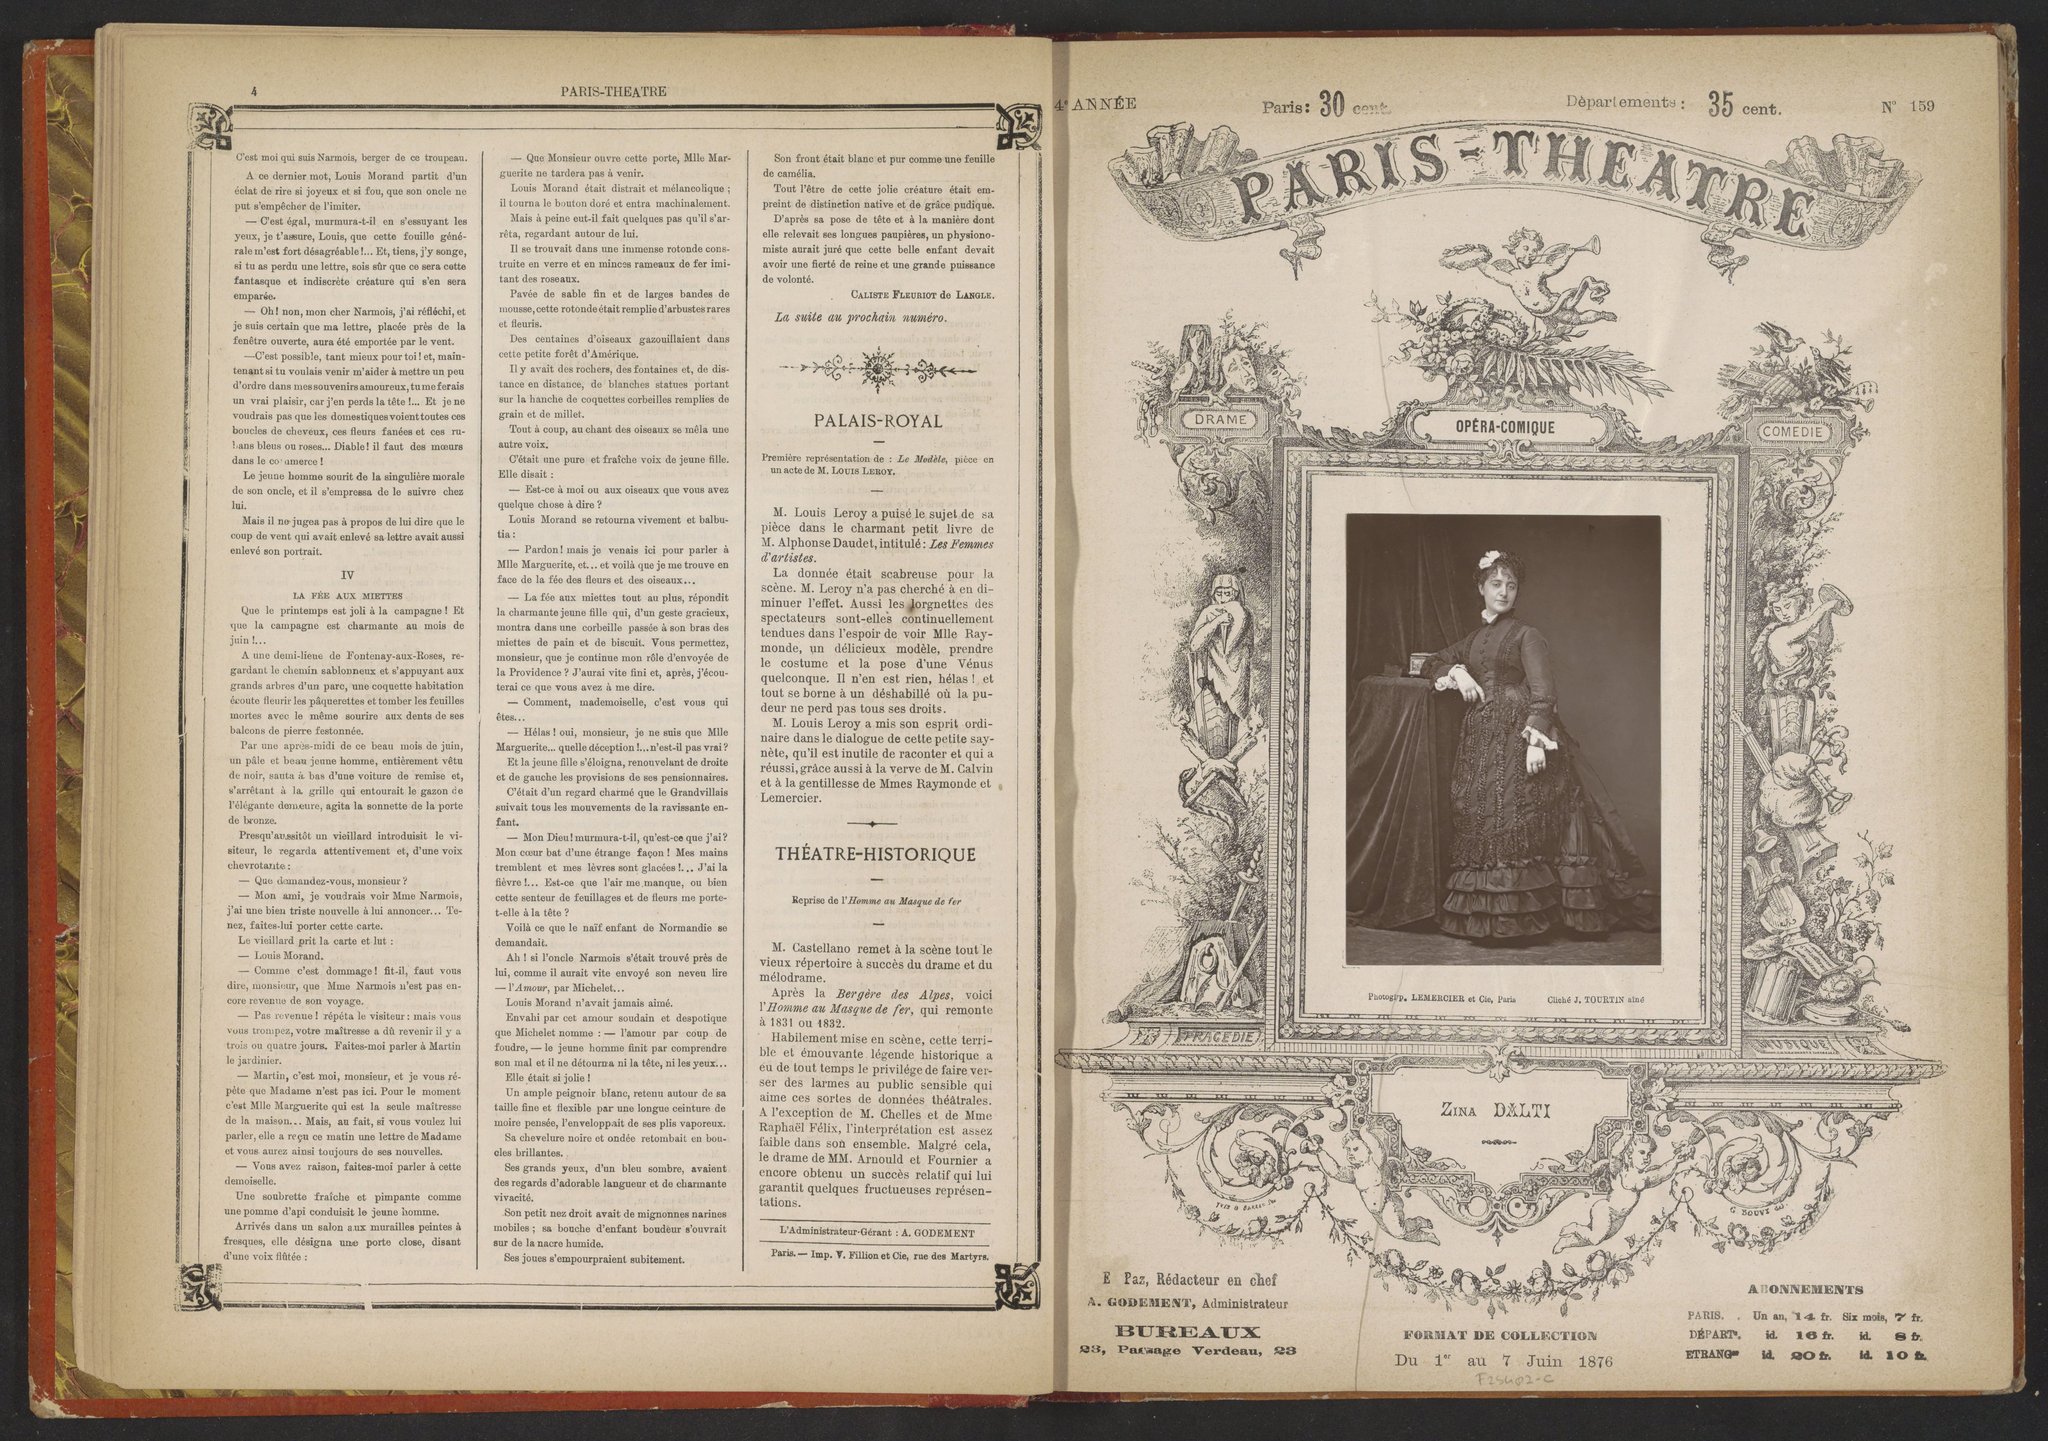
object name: page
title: Portret van Zina Dalti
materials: paper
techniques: woodburytype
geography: france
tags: portrait of opera-singer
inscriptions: number: ‘No 159’, inscription: ‘Du 1 au 7 Juin 1876’